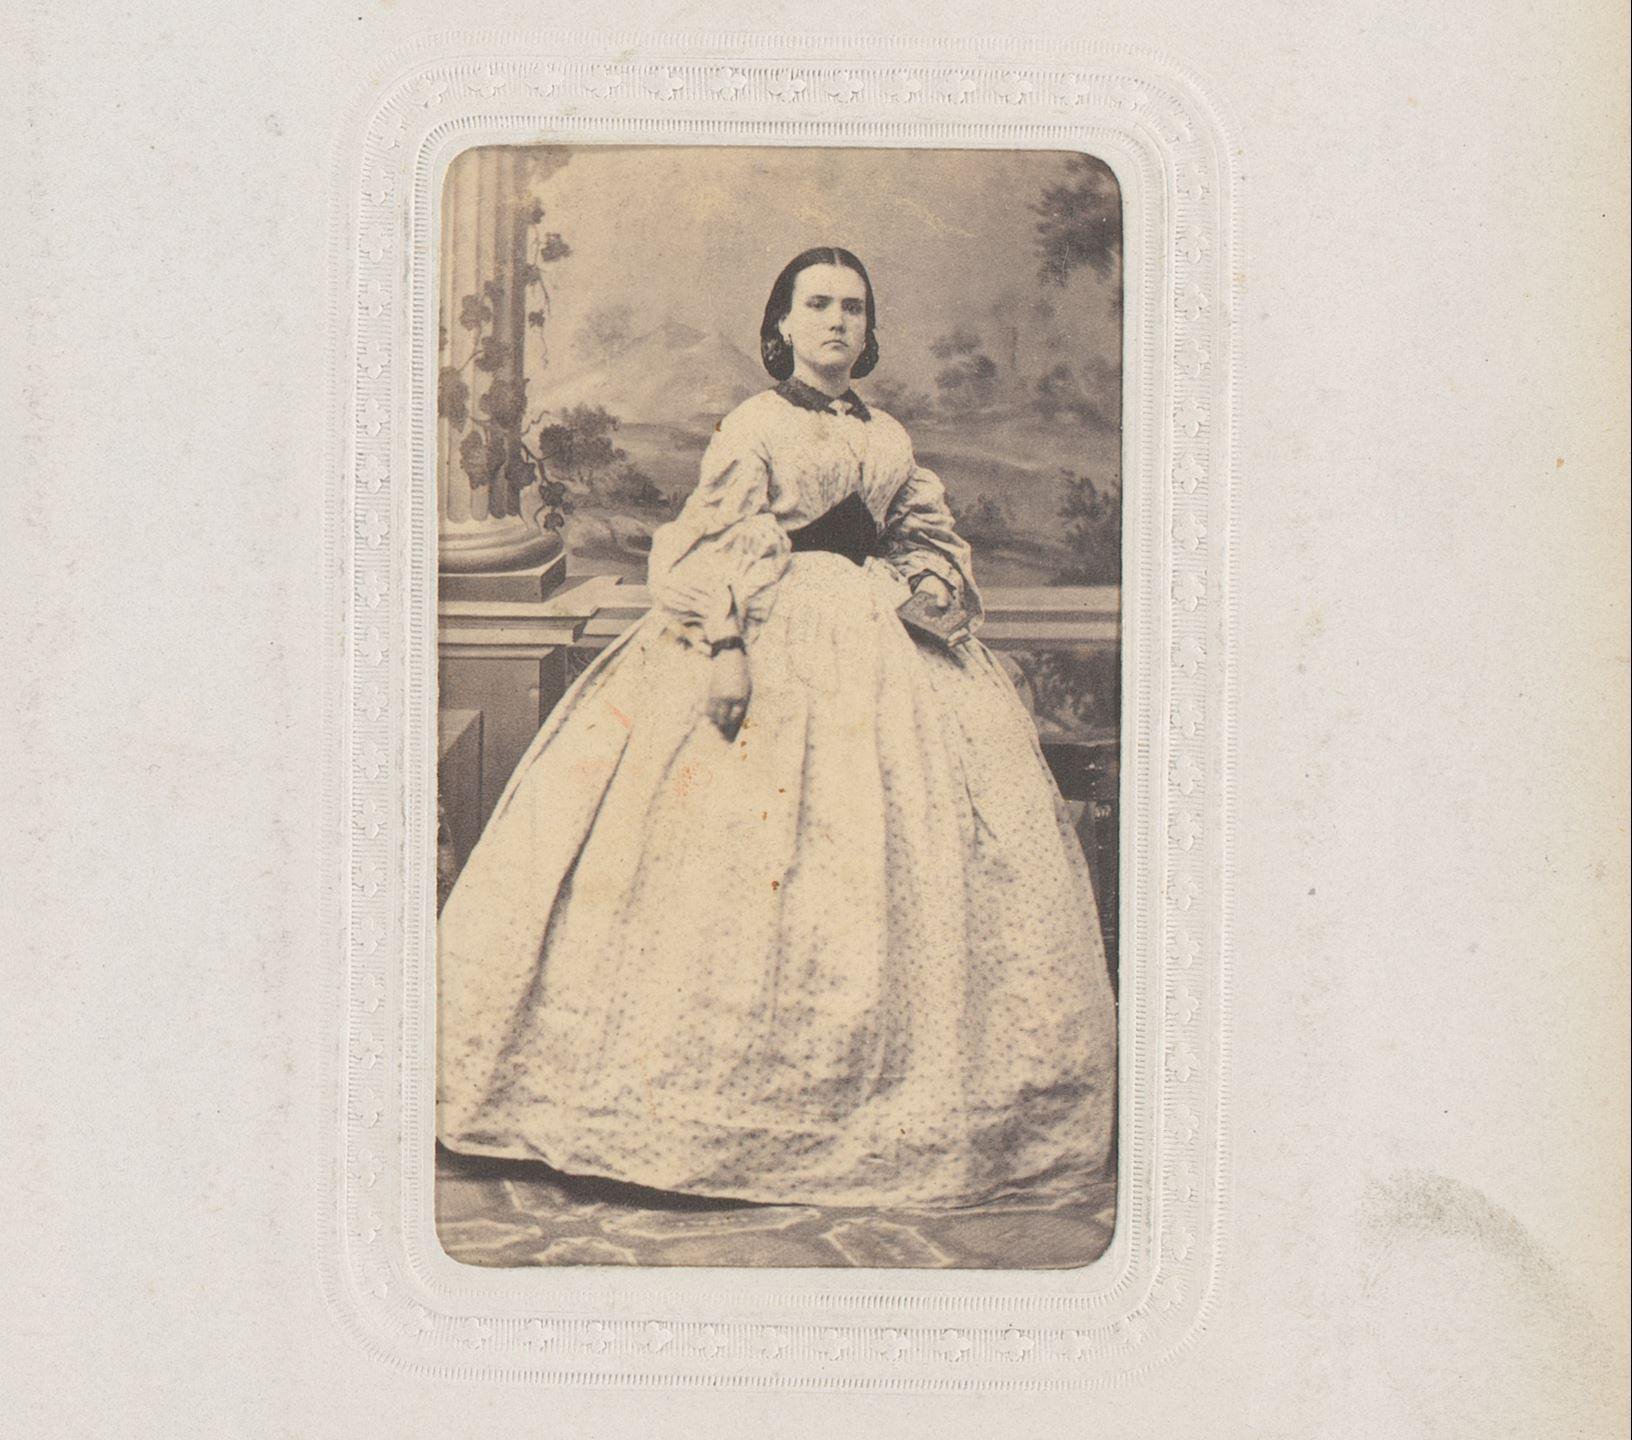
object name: photograph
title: Portret van een staande vrouw met boek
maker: Anonymous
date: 1860-1890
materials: cardboard, photographic support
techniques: albumen print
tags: historical persons - bb - woman